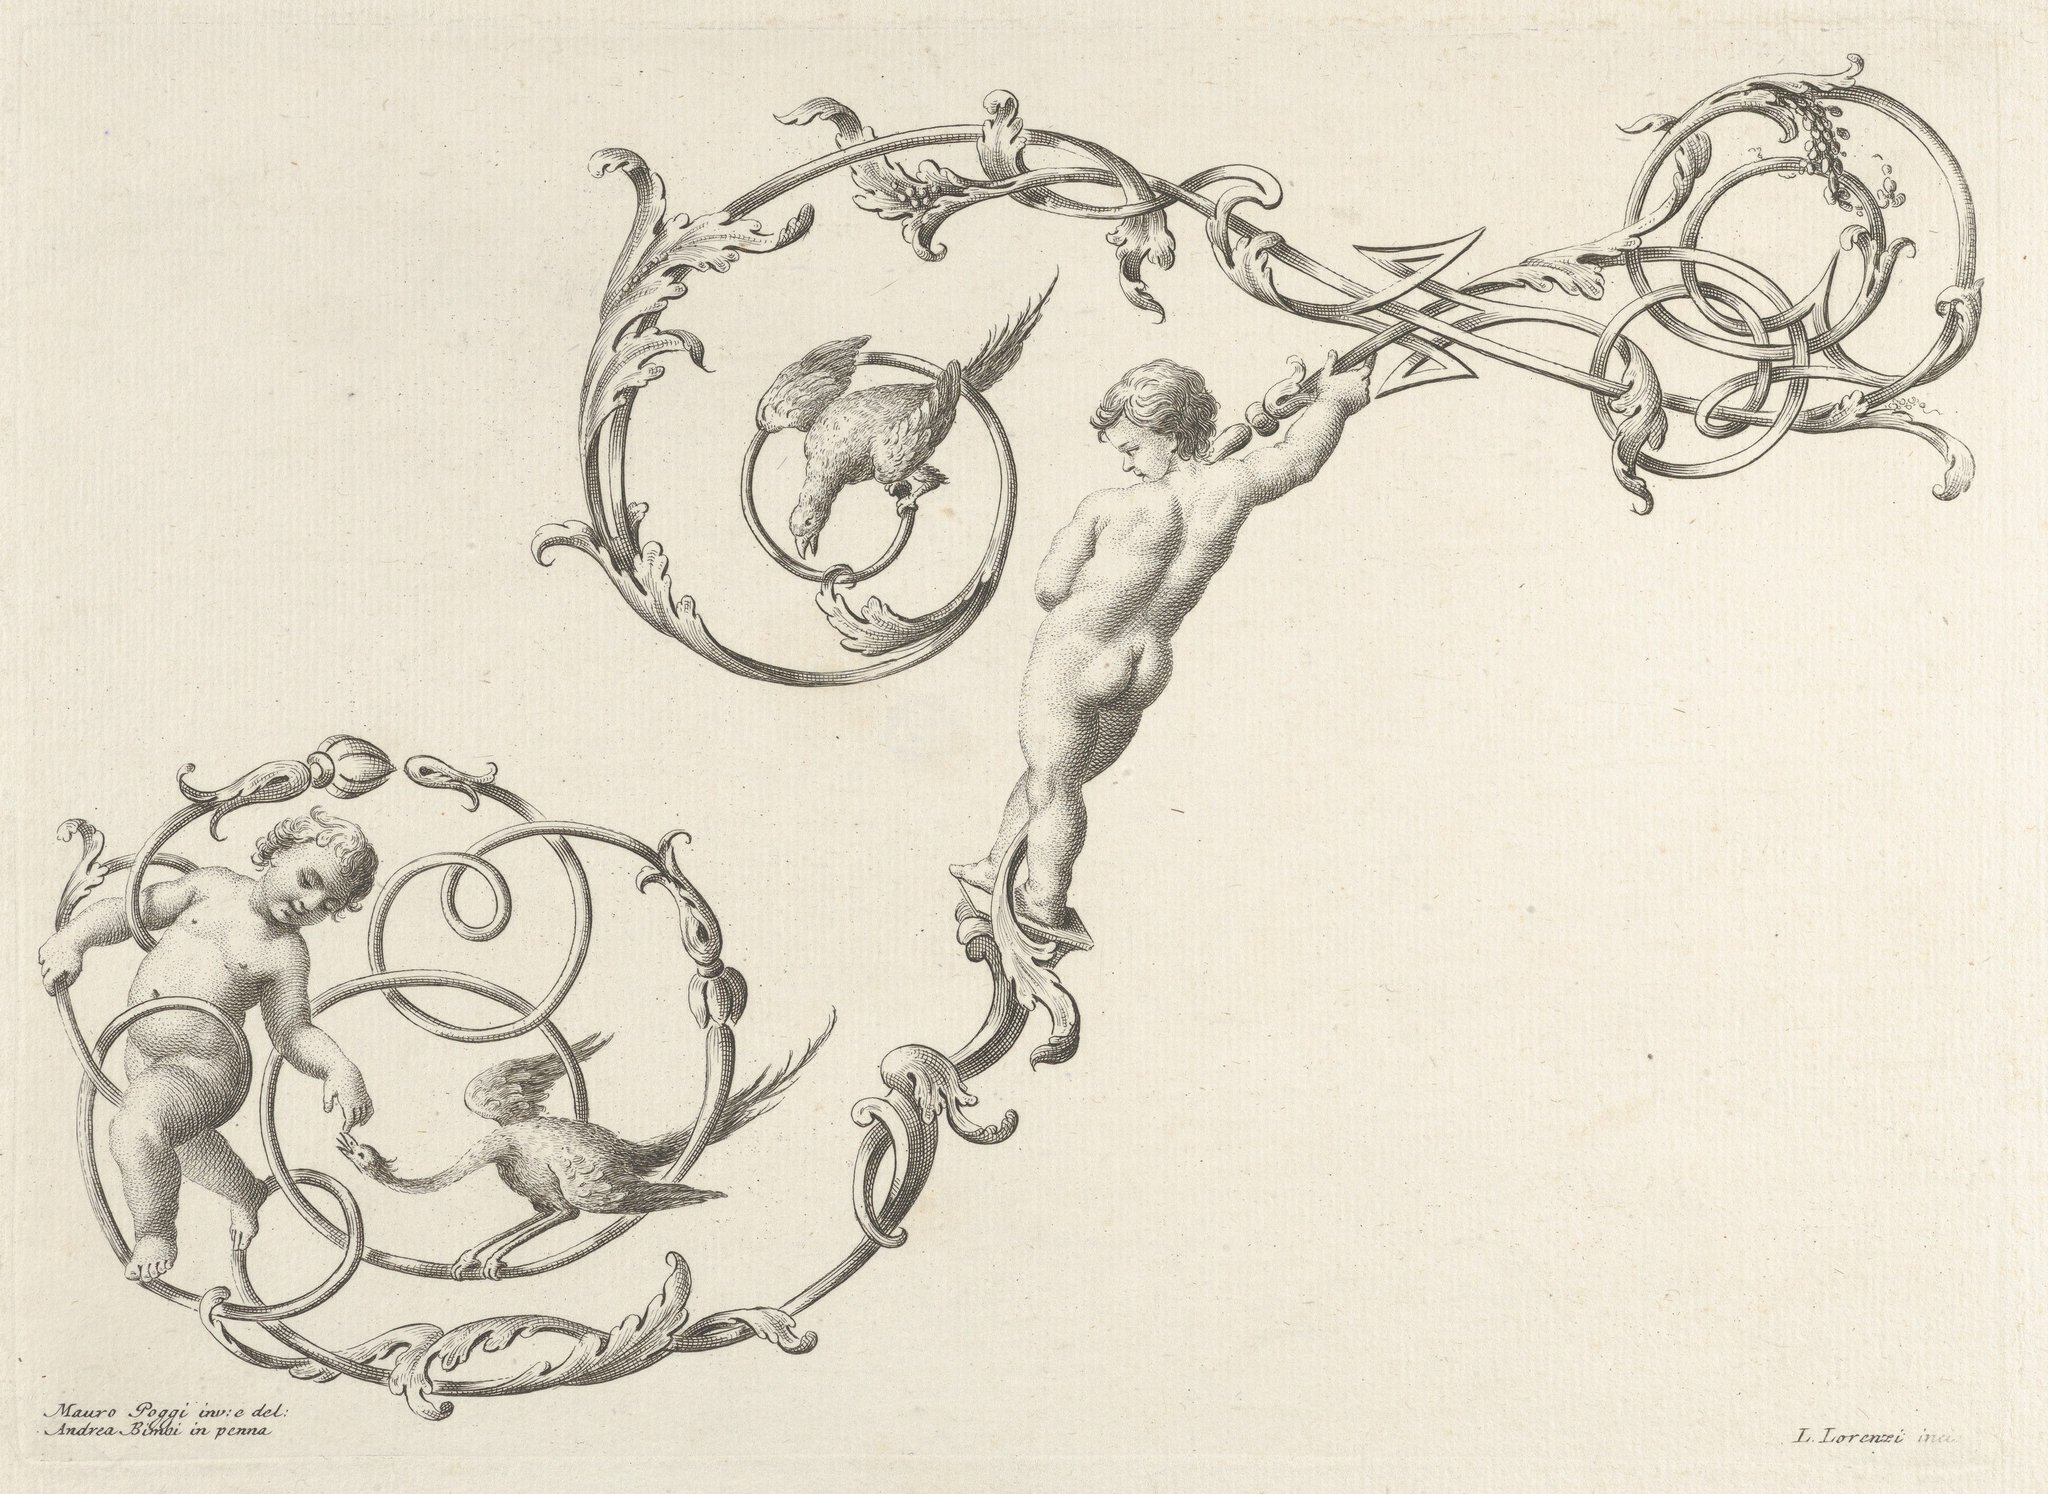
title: Alfabeto Di Lettere Iniziale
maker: mauro poggi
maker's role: designer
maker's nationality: italian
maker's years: 1700-1800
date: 1760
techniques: engraving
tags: birds,children